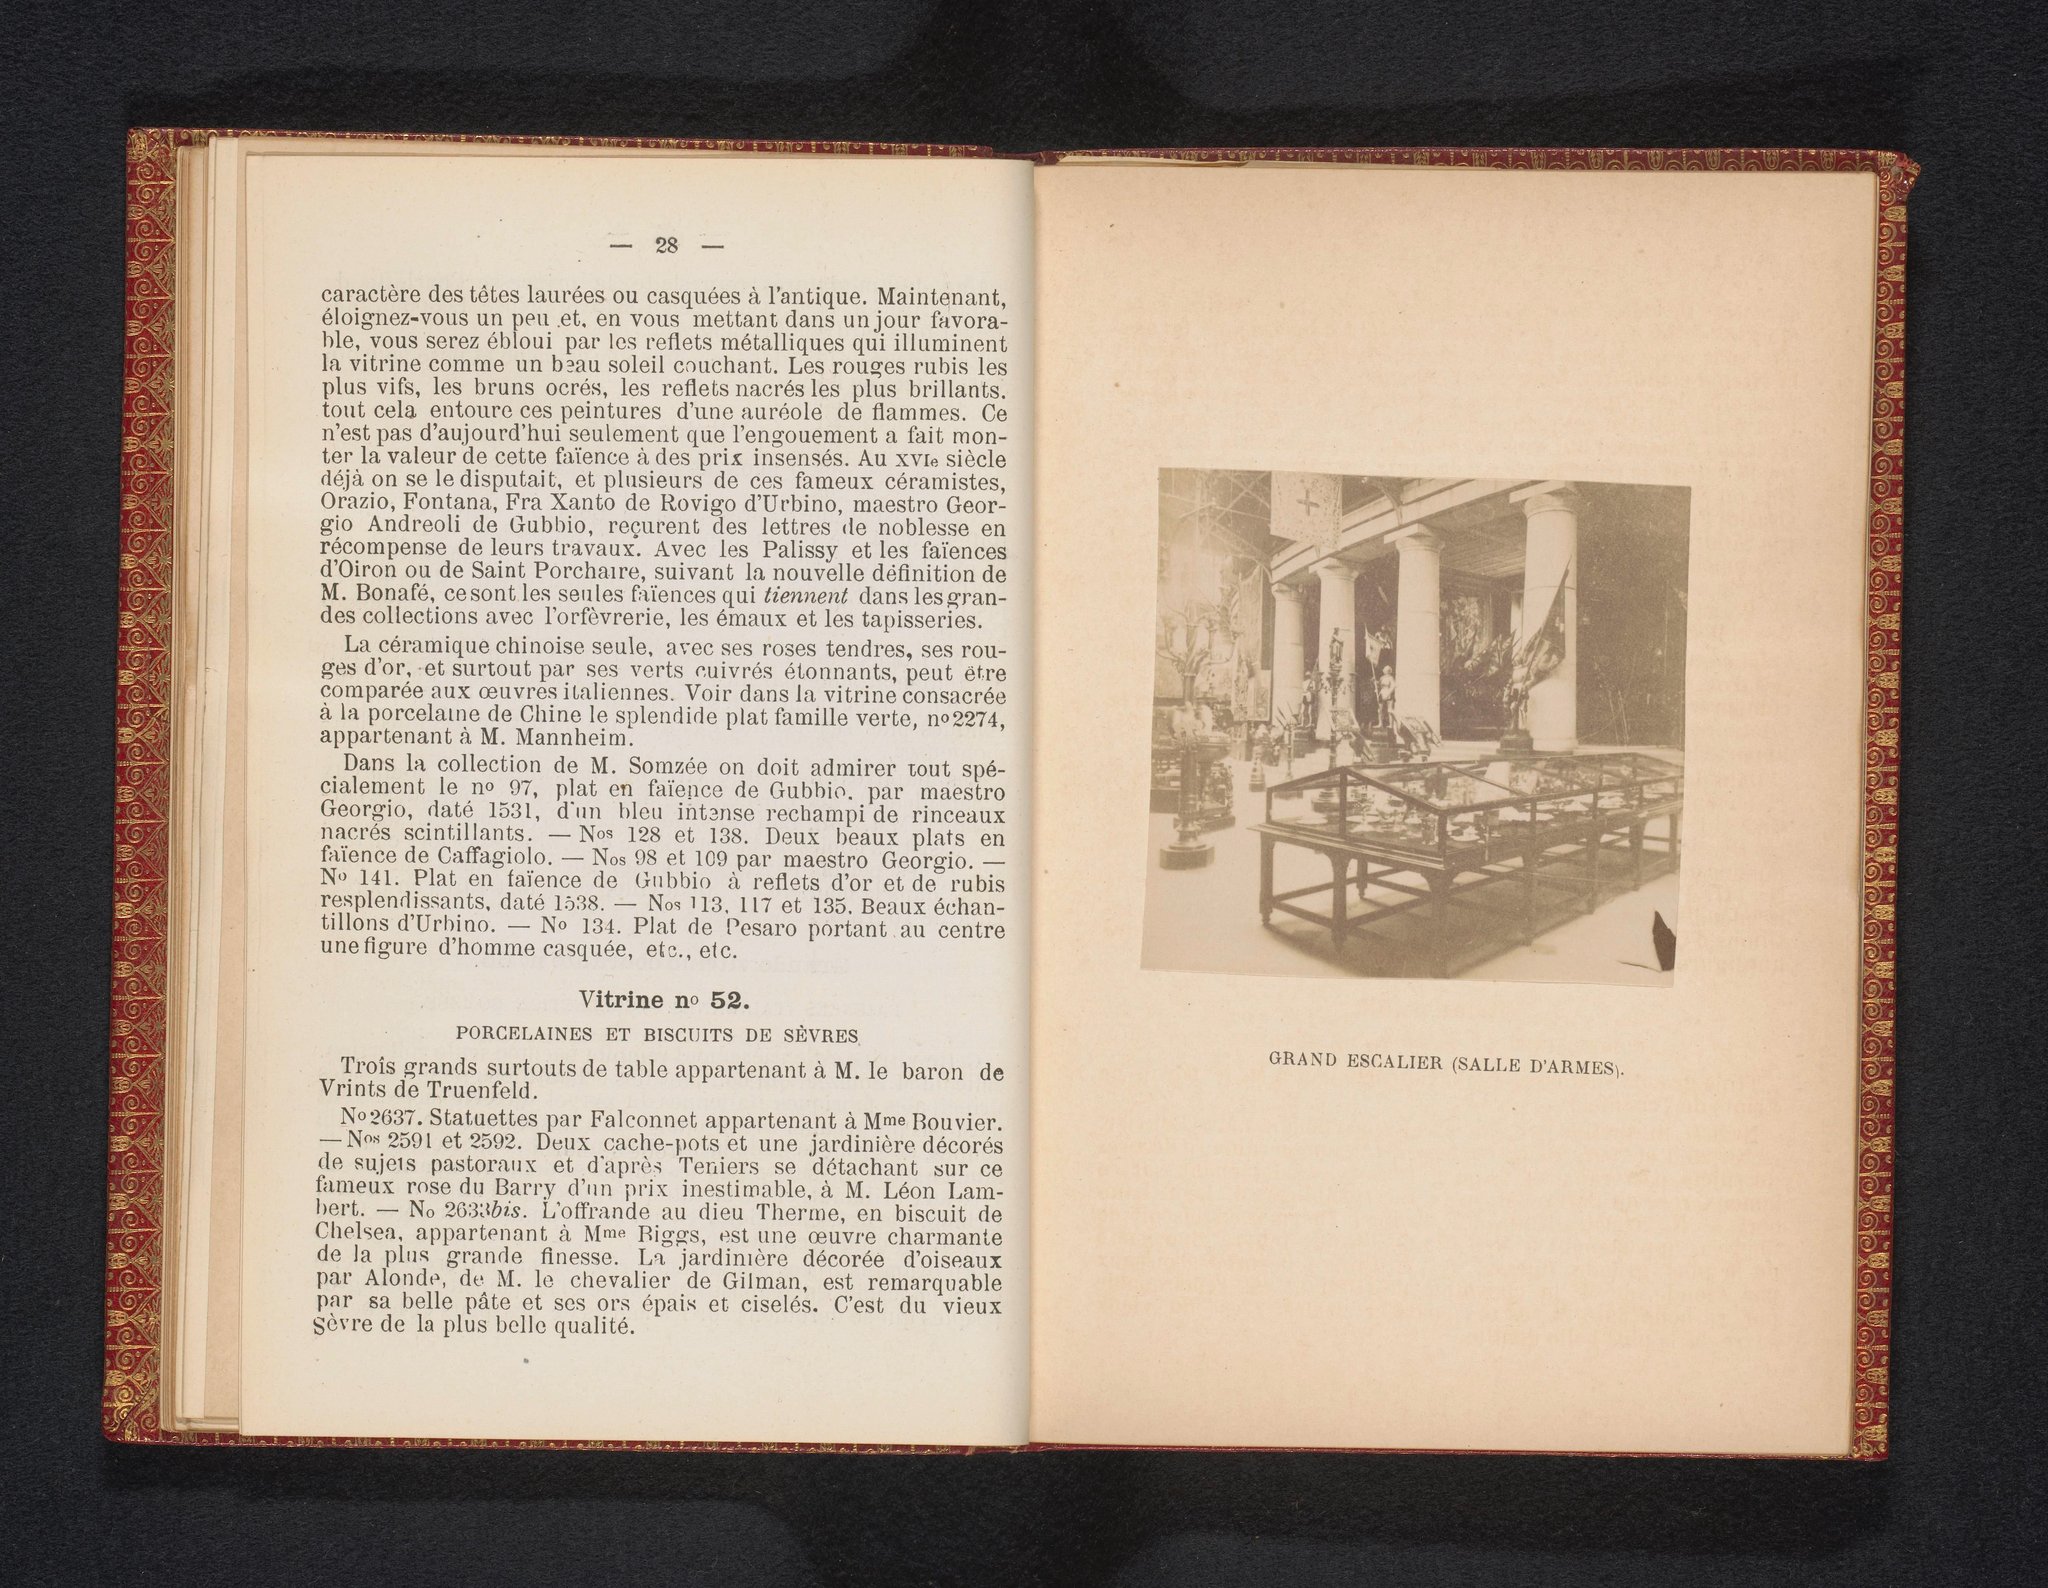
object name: photograph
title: Grand escalier (salle d'armes)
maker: Anonymous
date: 1888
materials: photographic support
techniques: albumen print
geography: brussels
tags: weapons, permanent exhibition, museum, brussels